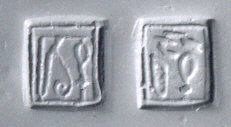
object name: stamp seal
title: Grooved plaque seal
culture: egyptian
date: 2150-2030 BCE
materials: bone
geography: egypt